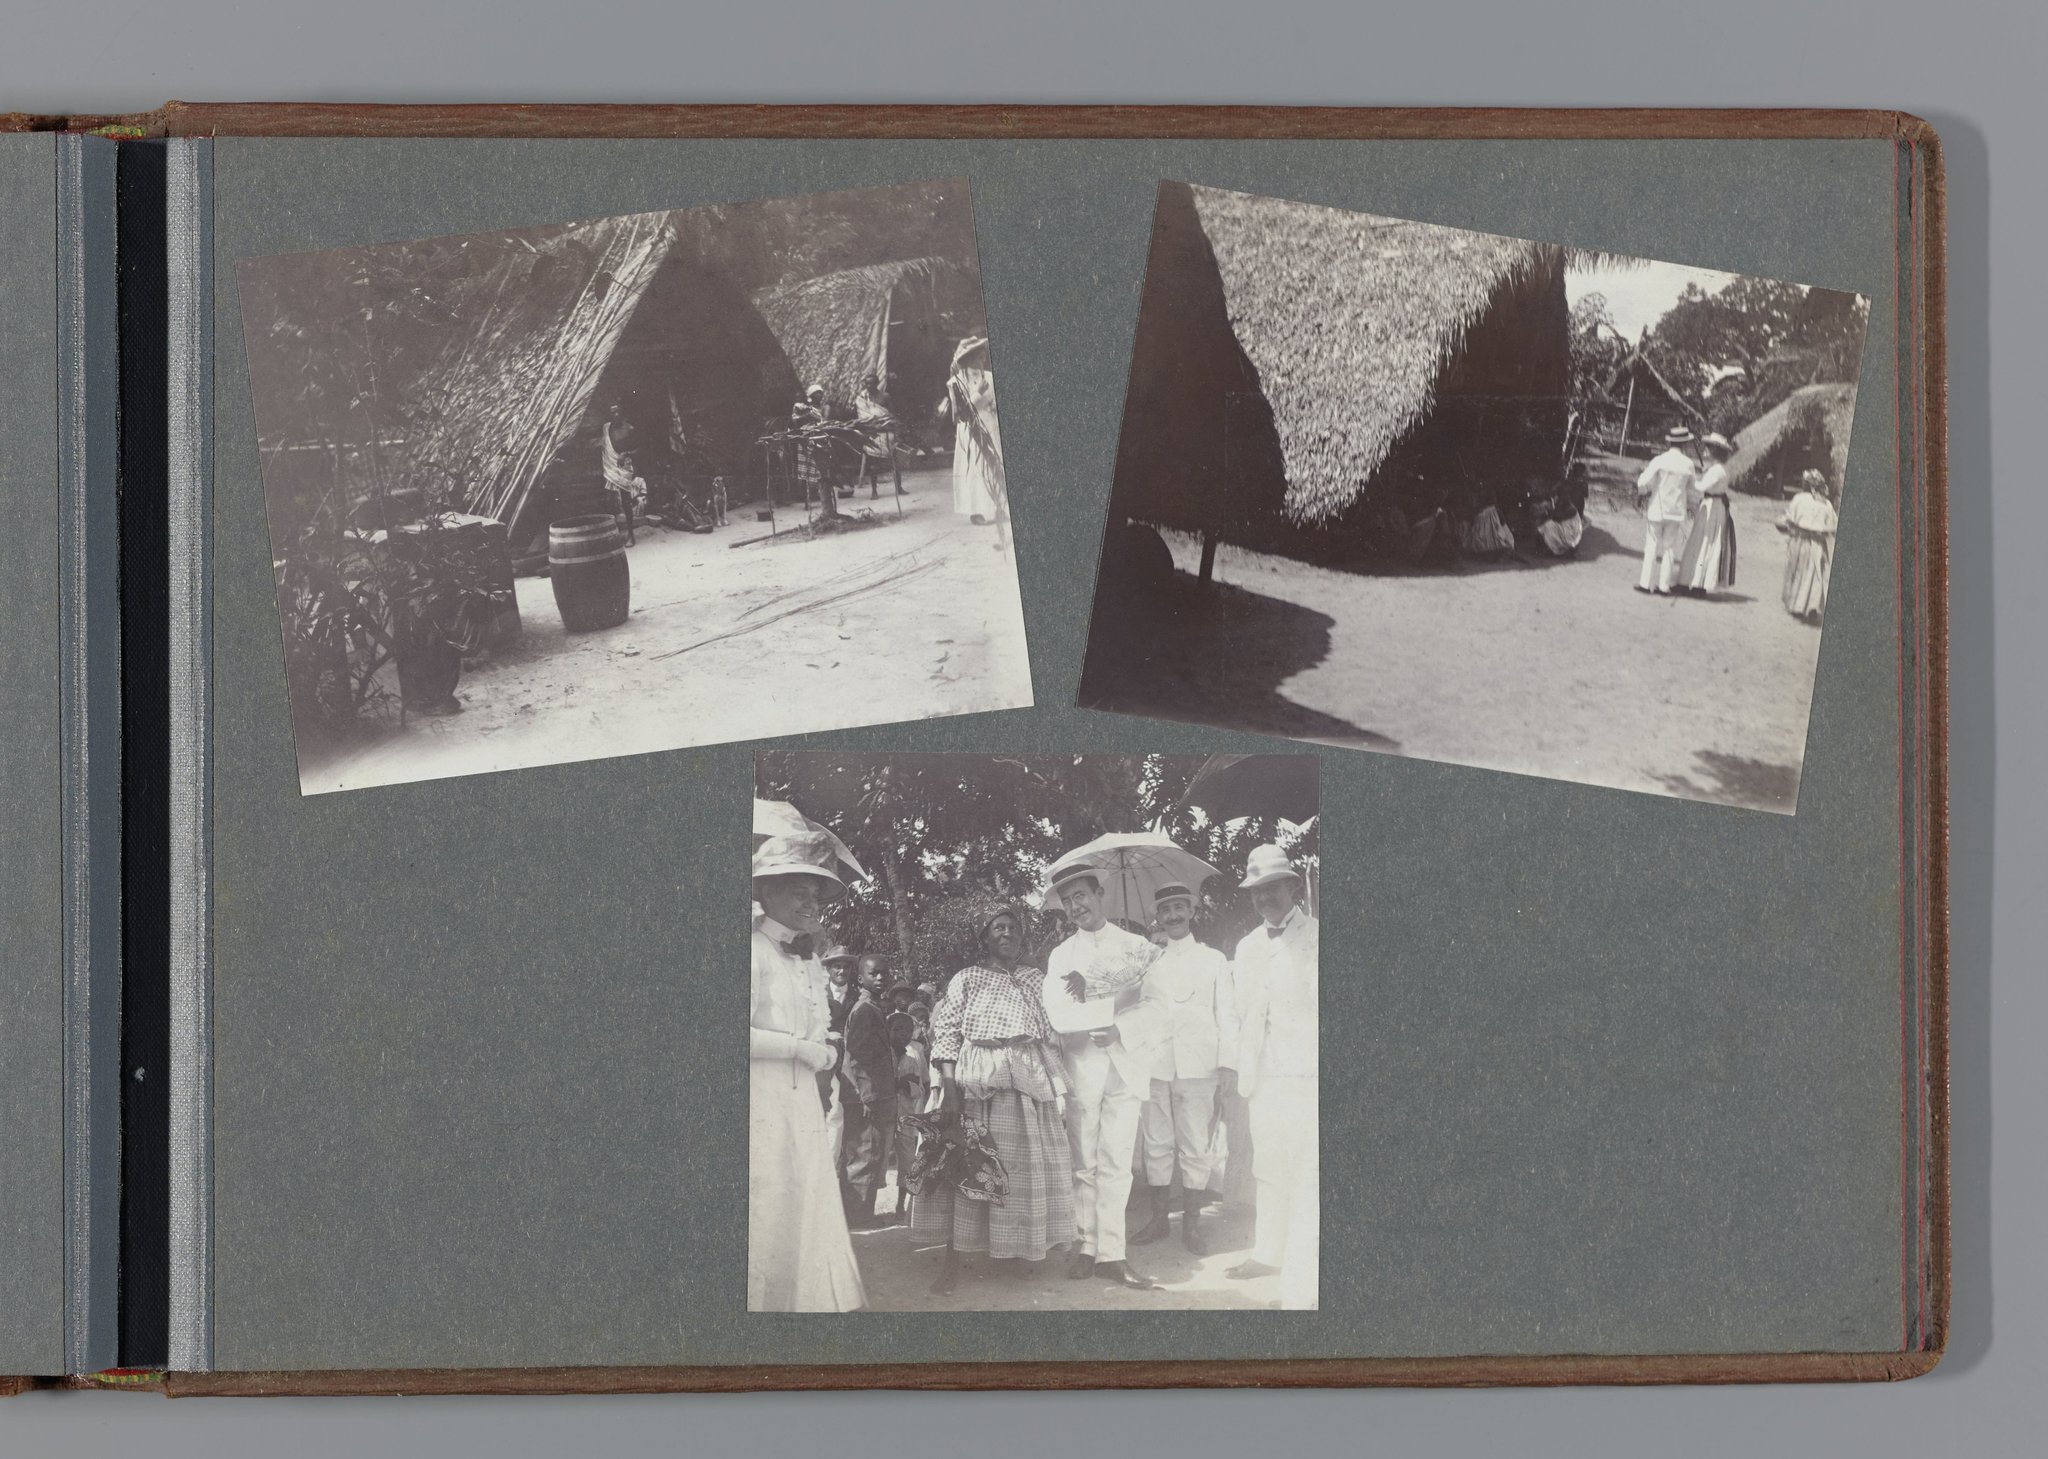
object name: photograph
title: Een Westers gekleed echtpaar bekijkt een Surinaamse hut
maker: Anonymous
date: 1905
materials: cardboard, paper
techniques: photography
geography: paramaribo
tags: suriname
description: Een Westers gekleed echtpaar bekijkt een Surinaamse hut. Onderdeel van fotoalbum 'Suriname'.